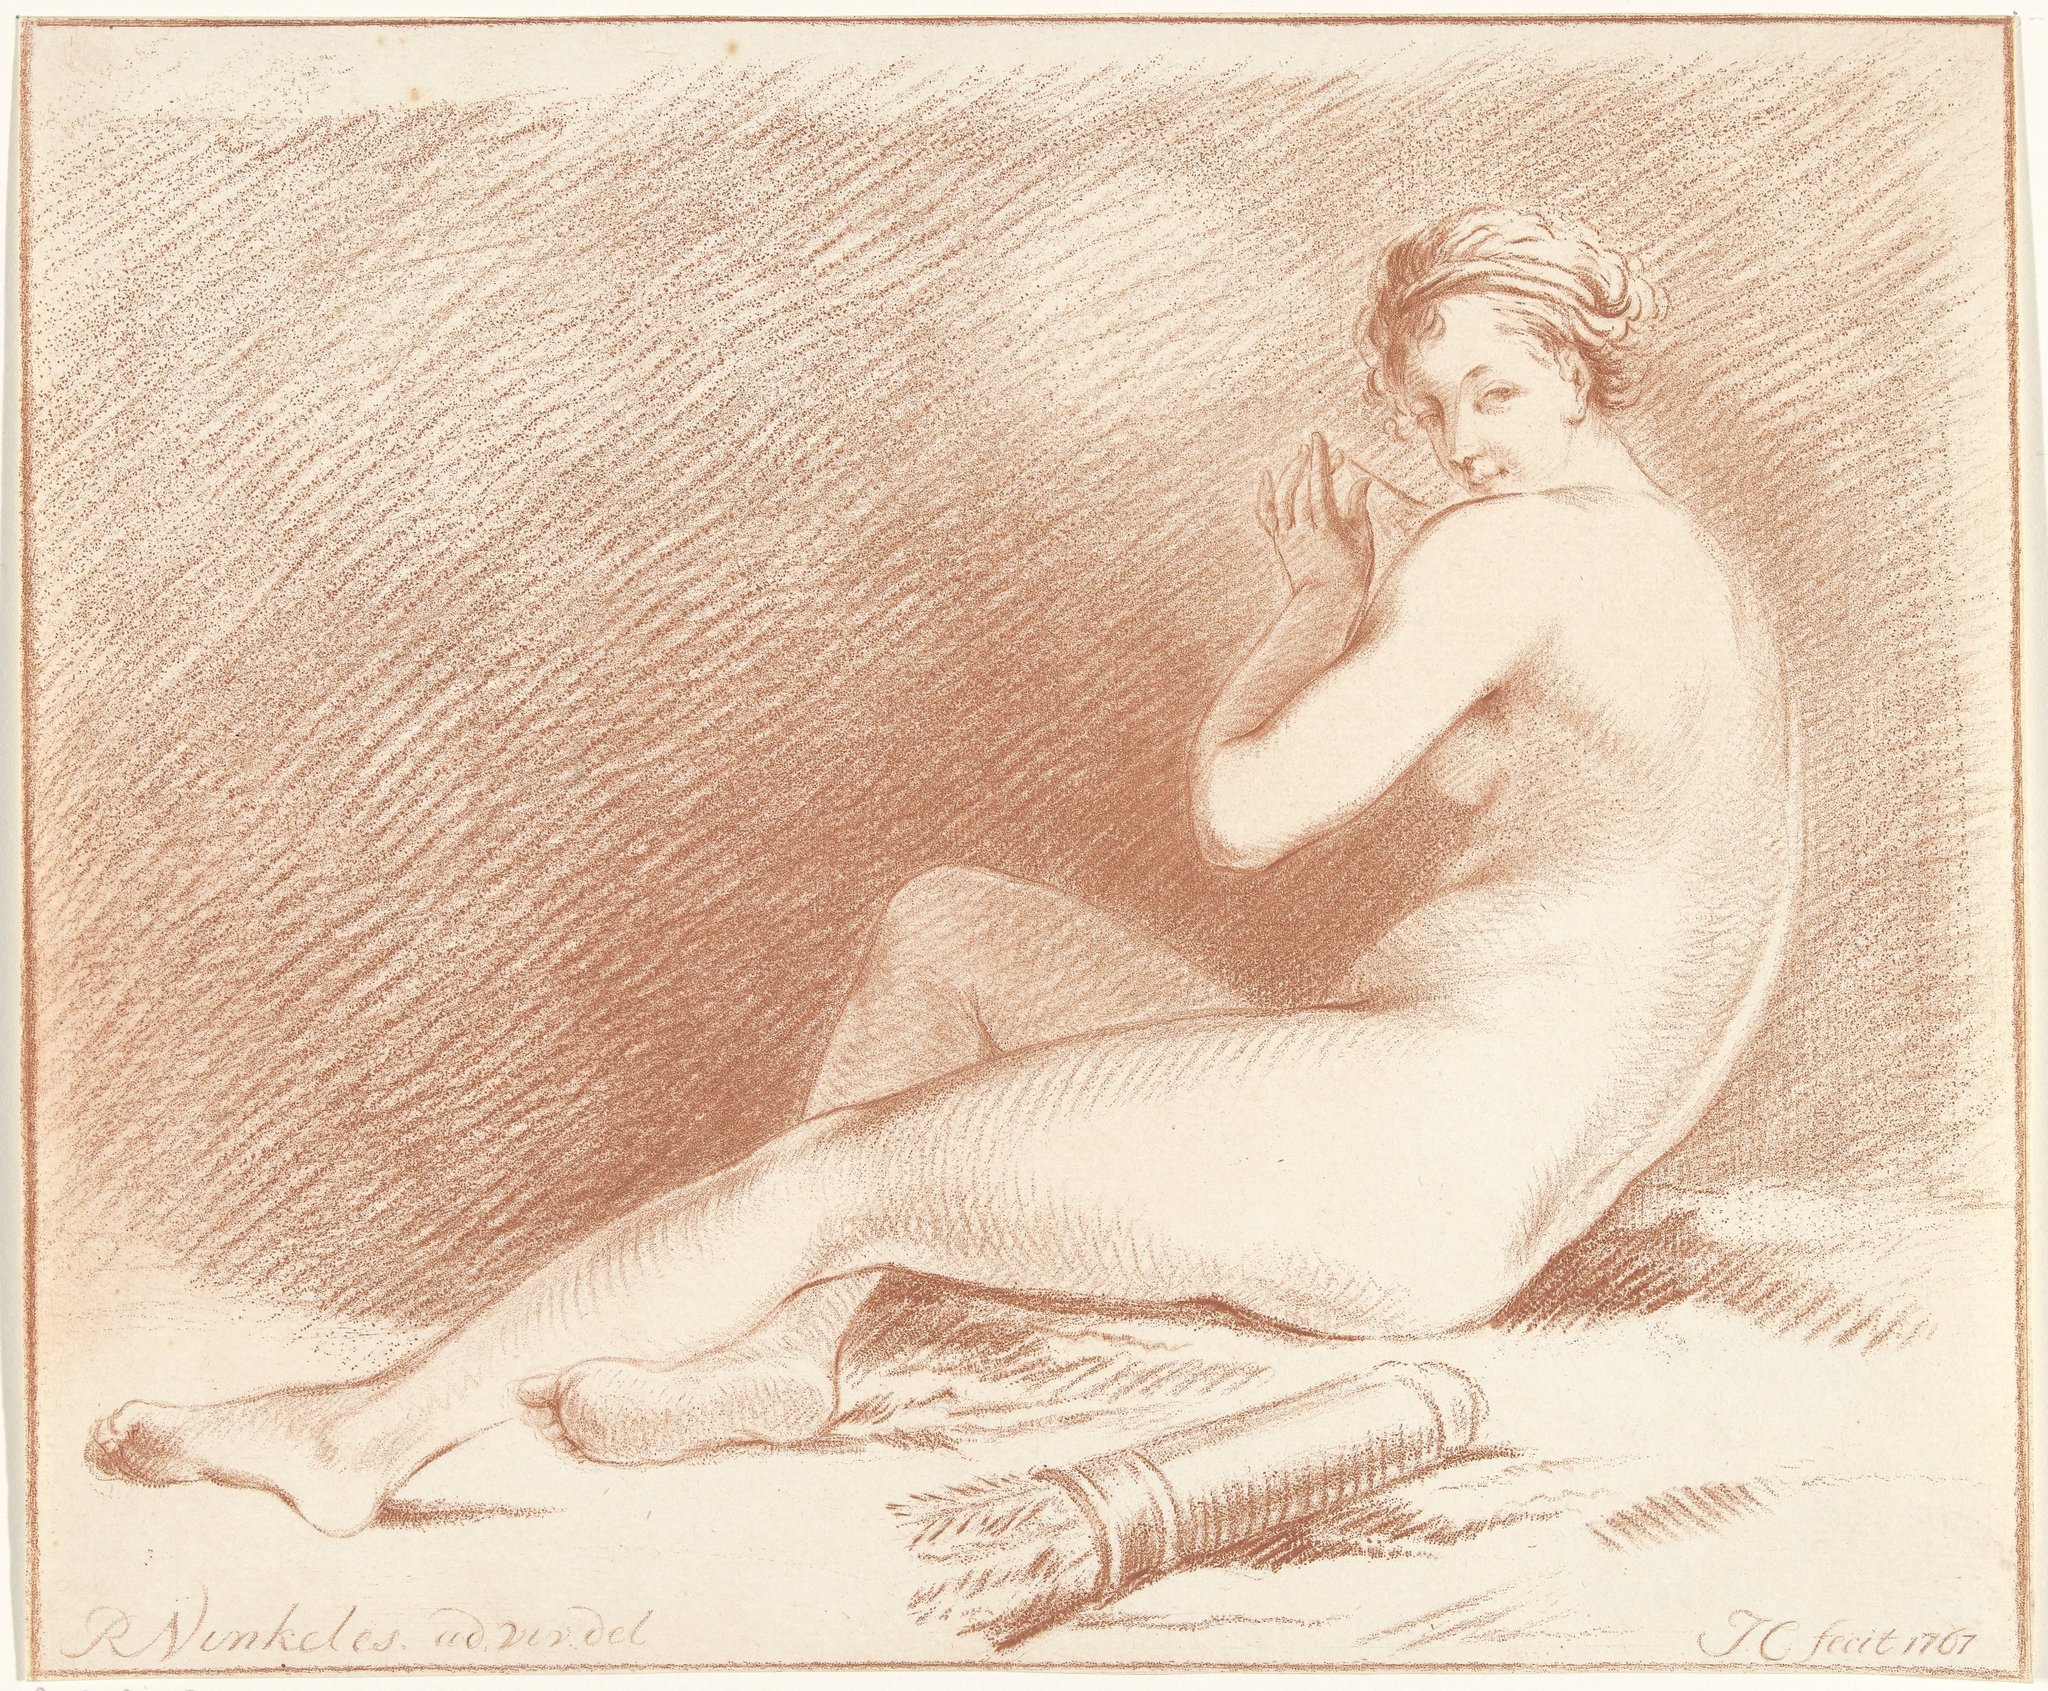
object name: print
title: Venus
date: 1767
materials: paper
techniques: printmaking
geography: amsterdam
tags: attributes of cupid: quiver, (story of) venus (aphrodite)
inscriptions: collector's mark: Lugt 240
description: Venus zit naakt op de grond, met haar rug naar voren. Op de grond naast haar ligt Cupido's pijlkoker